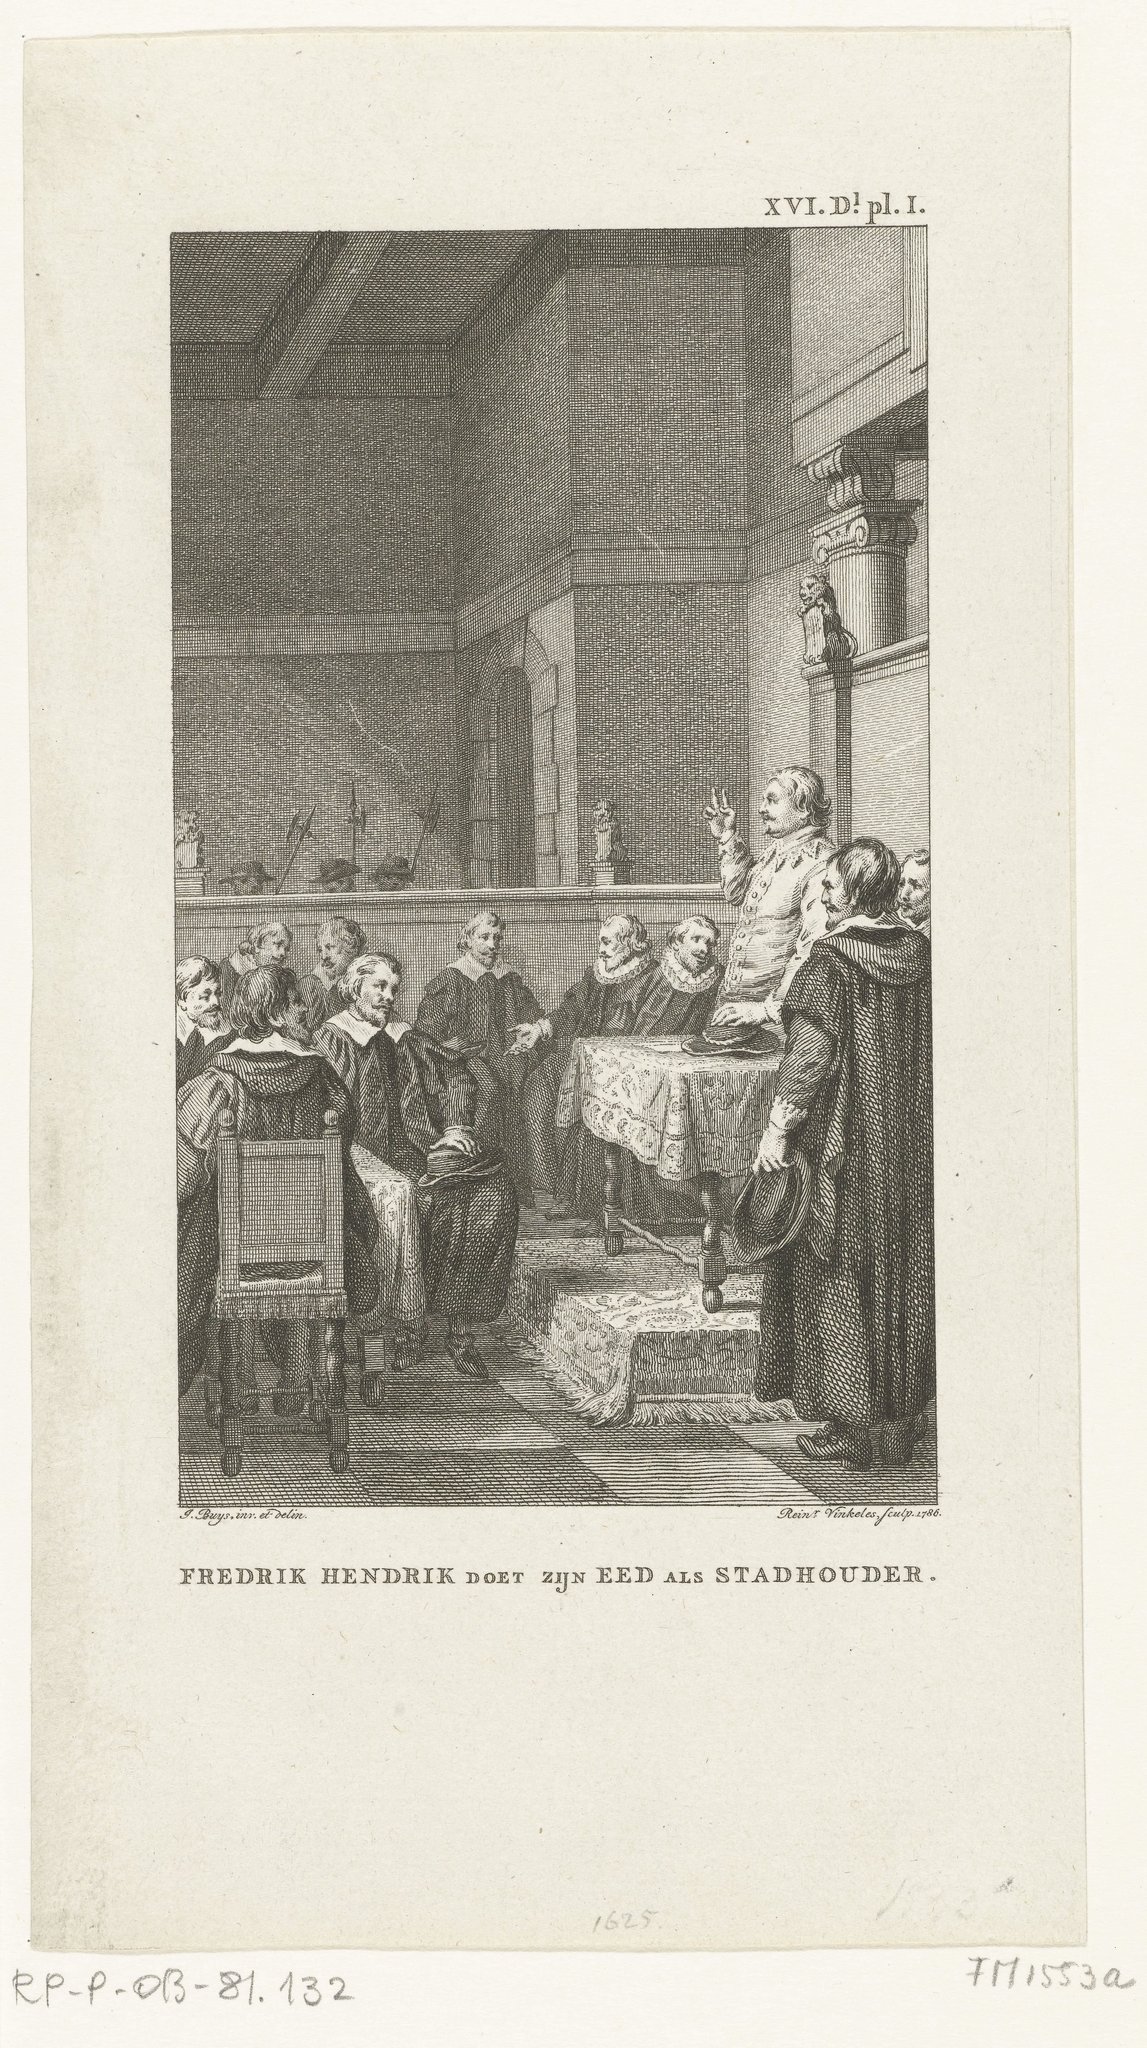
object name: history print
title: Frederik Hendrik doet zijn Eed als Stadhouder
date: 1786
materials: paper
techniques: etching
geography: netherlands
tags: delft, frederick henry (prince of orange), new ruler taking the oath, popular representation ~ government, the hague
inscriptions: date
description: Gebruikt als illustratie in: Jacobus Kok, Vaderlandsch Woordenboek, Johannes Allart, Amsterdam 1785-1799, 35 delen, dl. XVI, pl. I.